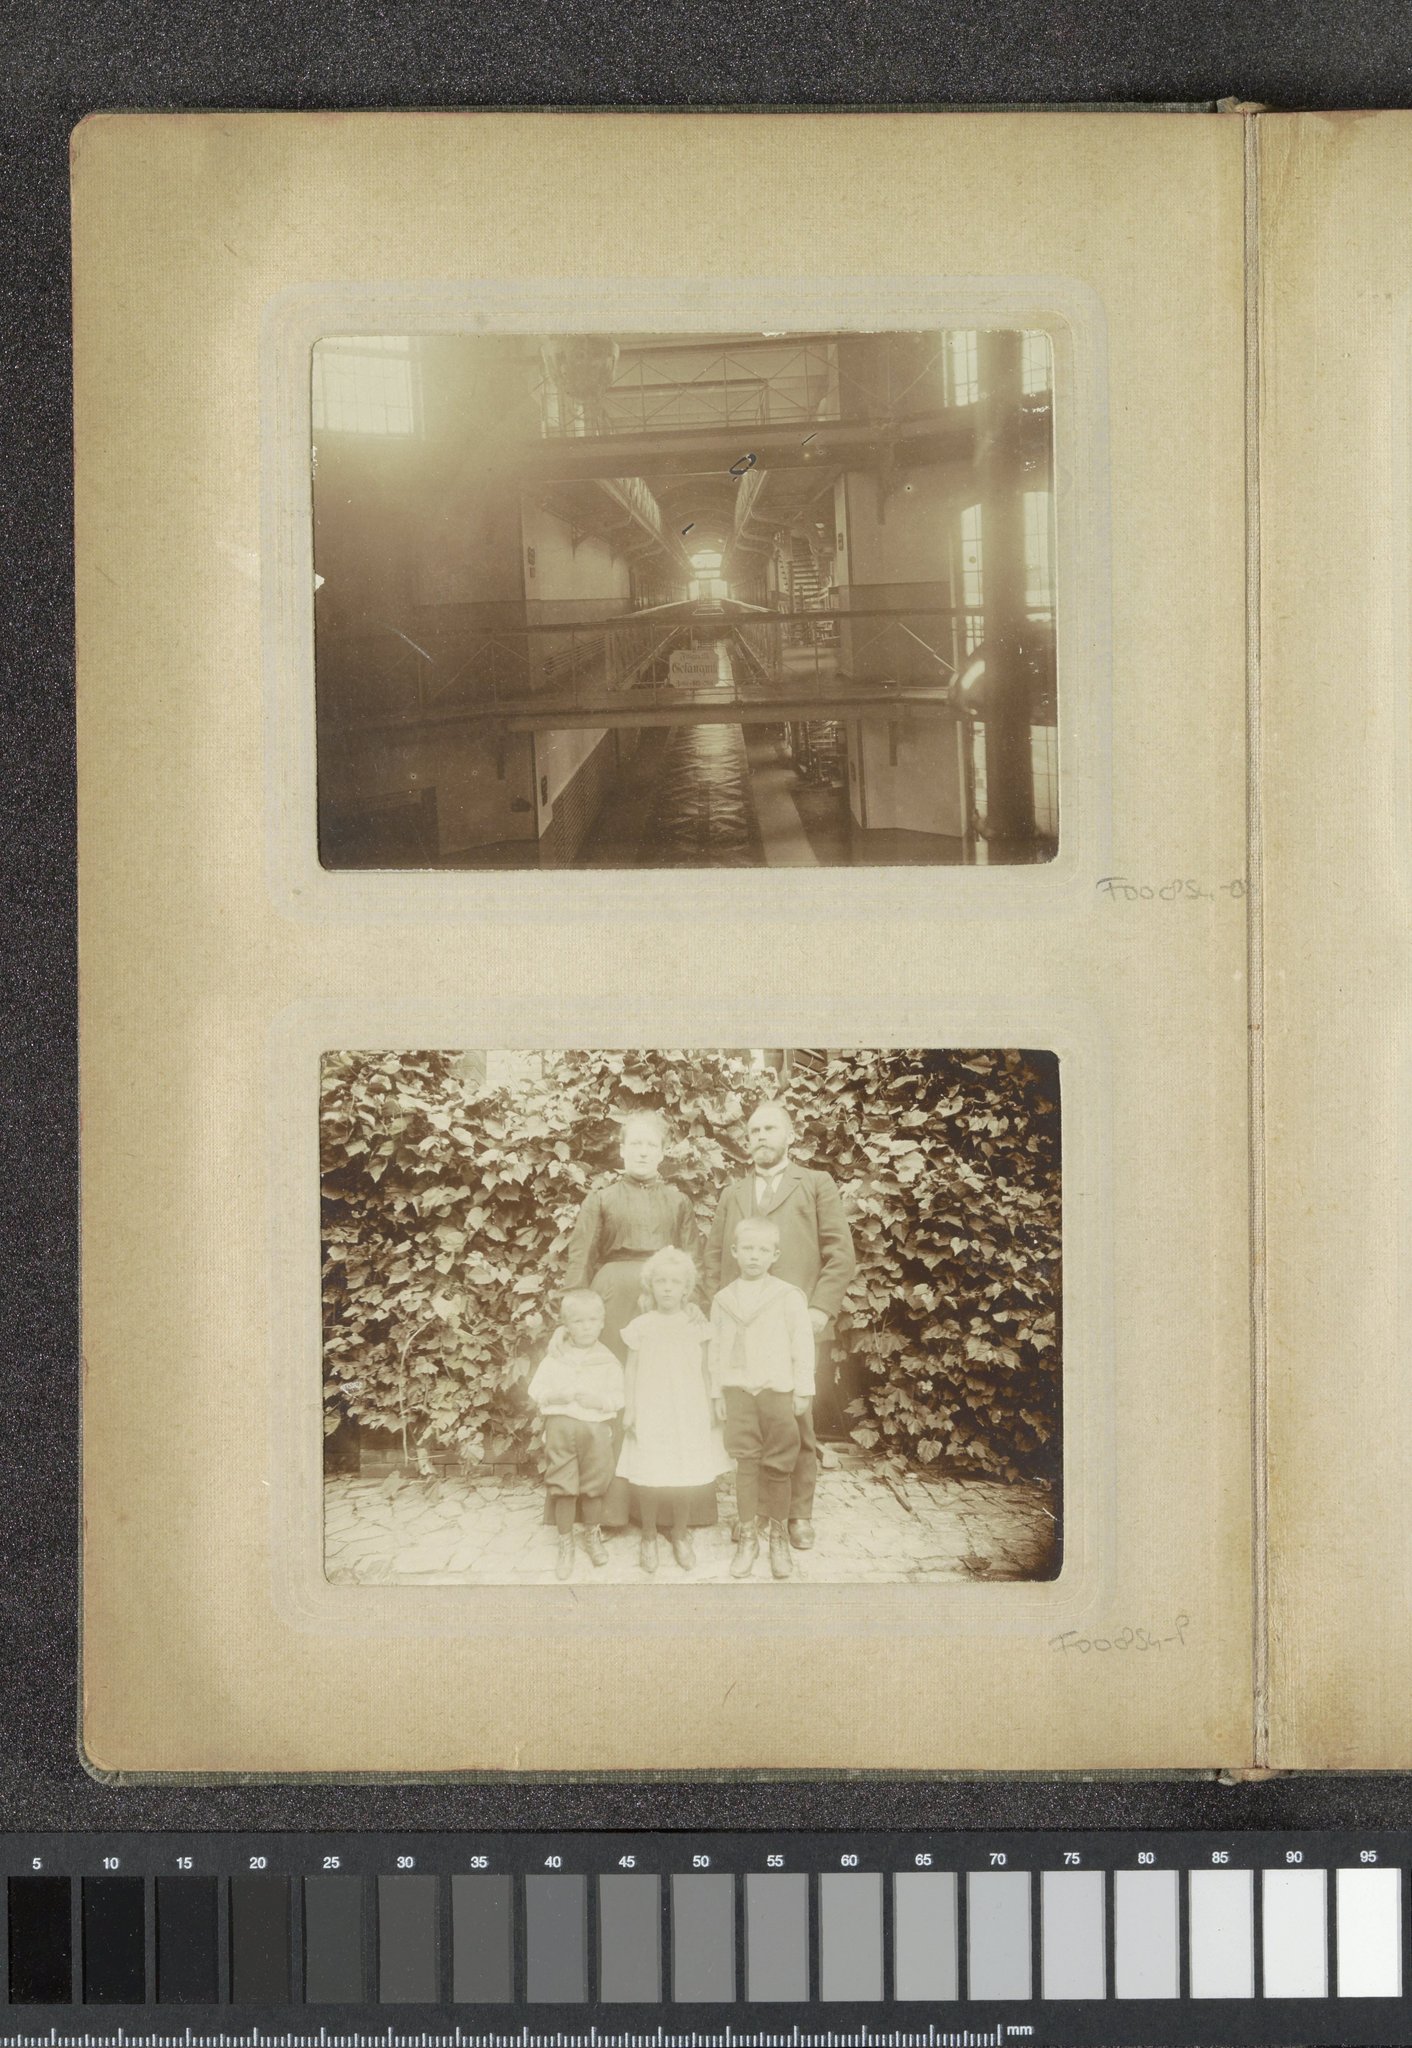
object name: photograph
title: Portret van een stel met drie kinderen staand voor een begroeide gevel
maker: Anonymous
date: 1890-1910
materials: cardboard, paper, photographic support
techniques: daylight paper print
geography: germany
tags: parents with their children, germany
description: Onderdeel van Fotoalbum van Carl Heinrich Fliegenschmidt, gevangenisdirecteur te Oslebshausen.